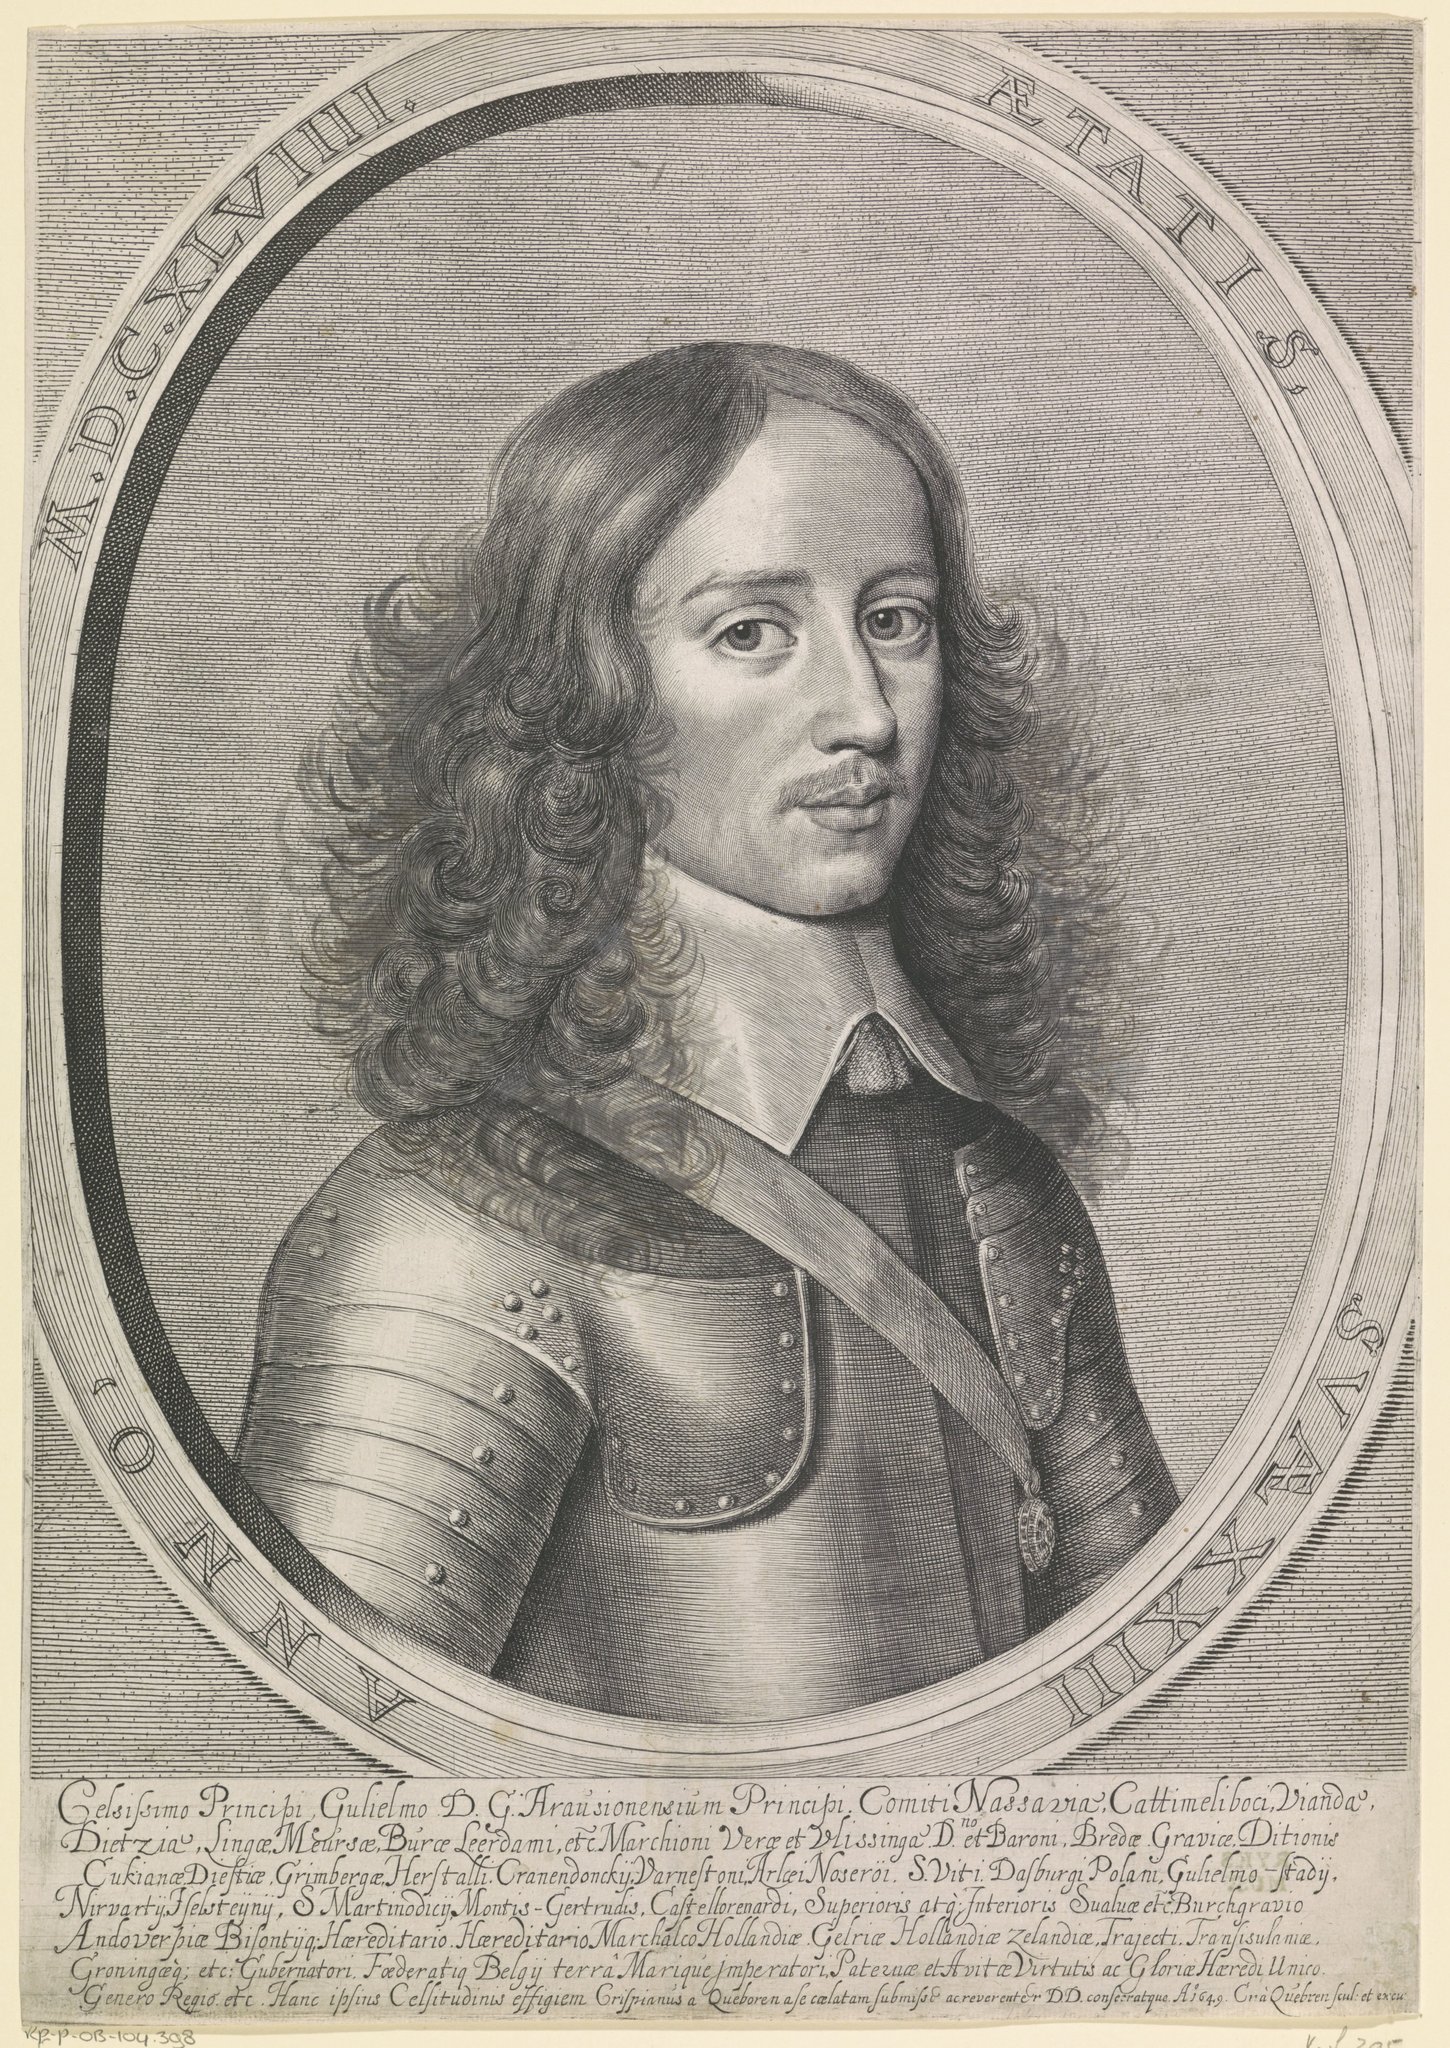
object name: print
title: Portret van Willem II, prins van Oranje, op 23-jarige leeftijd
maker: crispijn van den queborn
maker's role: print maker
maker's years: 1595-1652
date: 1649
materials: paper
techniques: engraving, etching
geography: amsterdam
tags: william ii (prince of orange), knighthood order (garter) - insignia of a knighthood order, e.g.: badge, chain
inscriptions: collector's mark: Lugt 963, collector's mark: Lugt 2165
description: De hier vermelde titel verwijst naar de hoogst verkregen titel van de geportretteerde, niet per se naar de titel die de geportretteerde op deze voorstelling draagt.